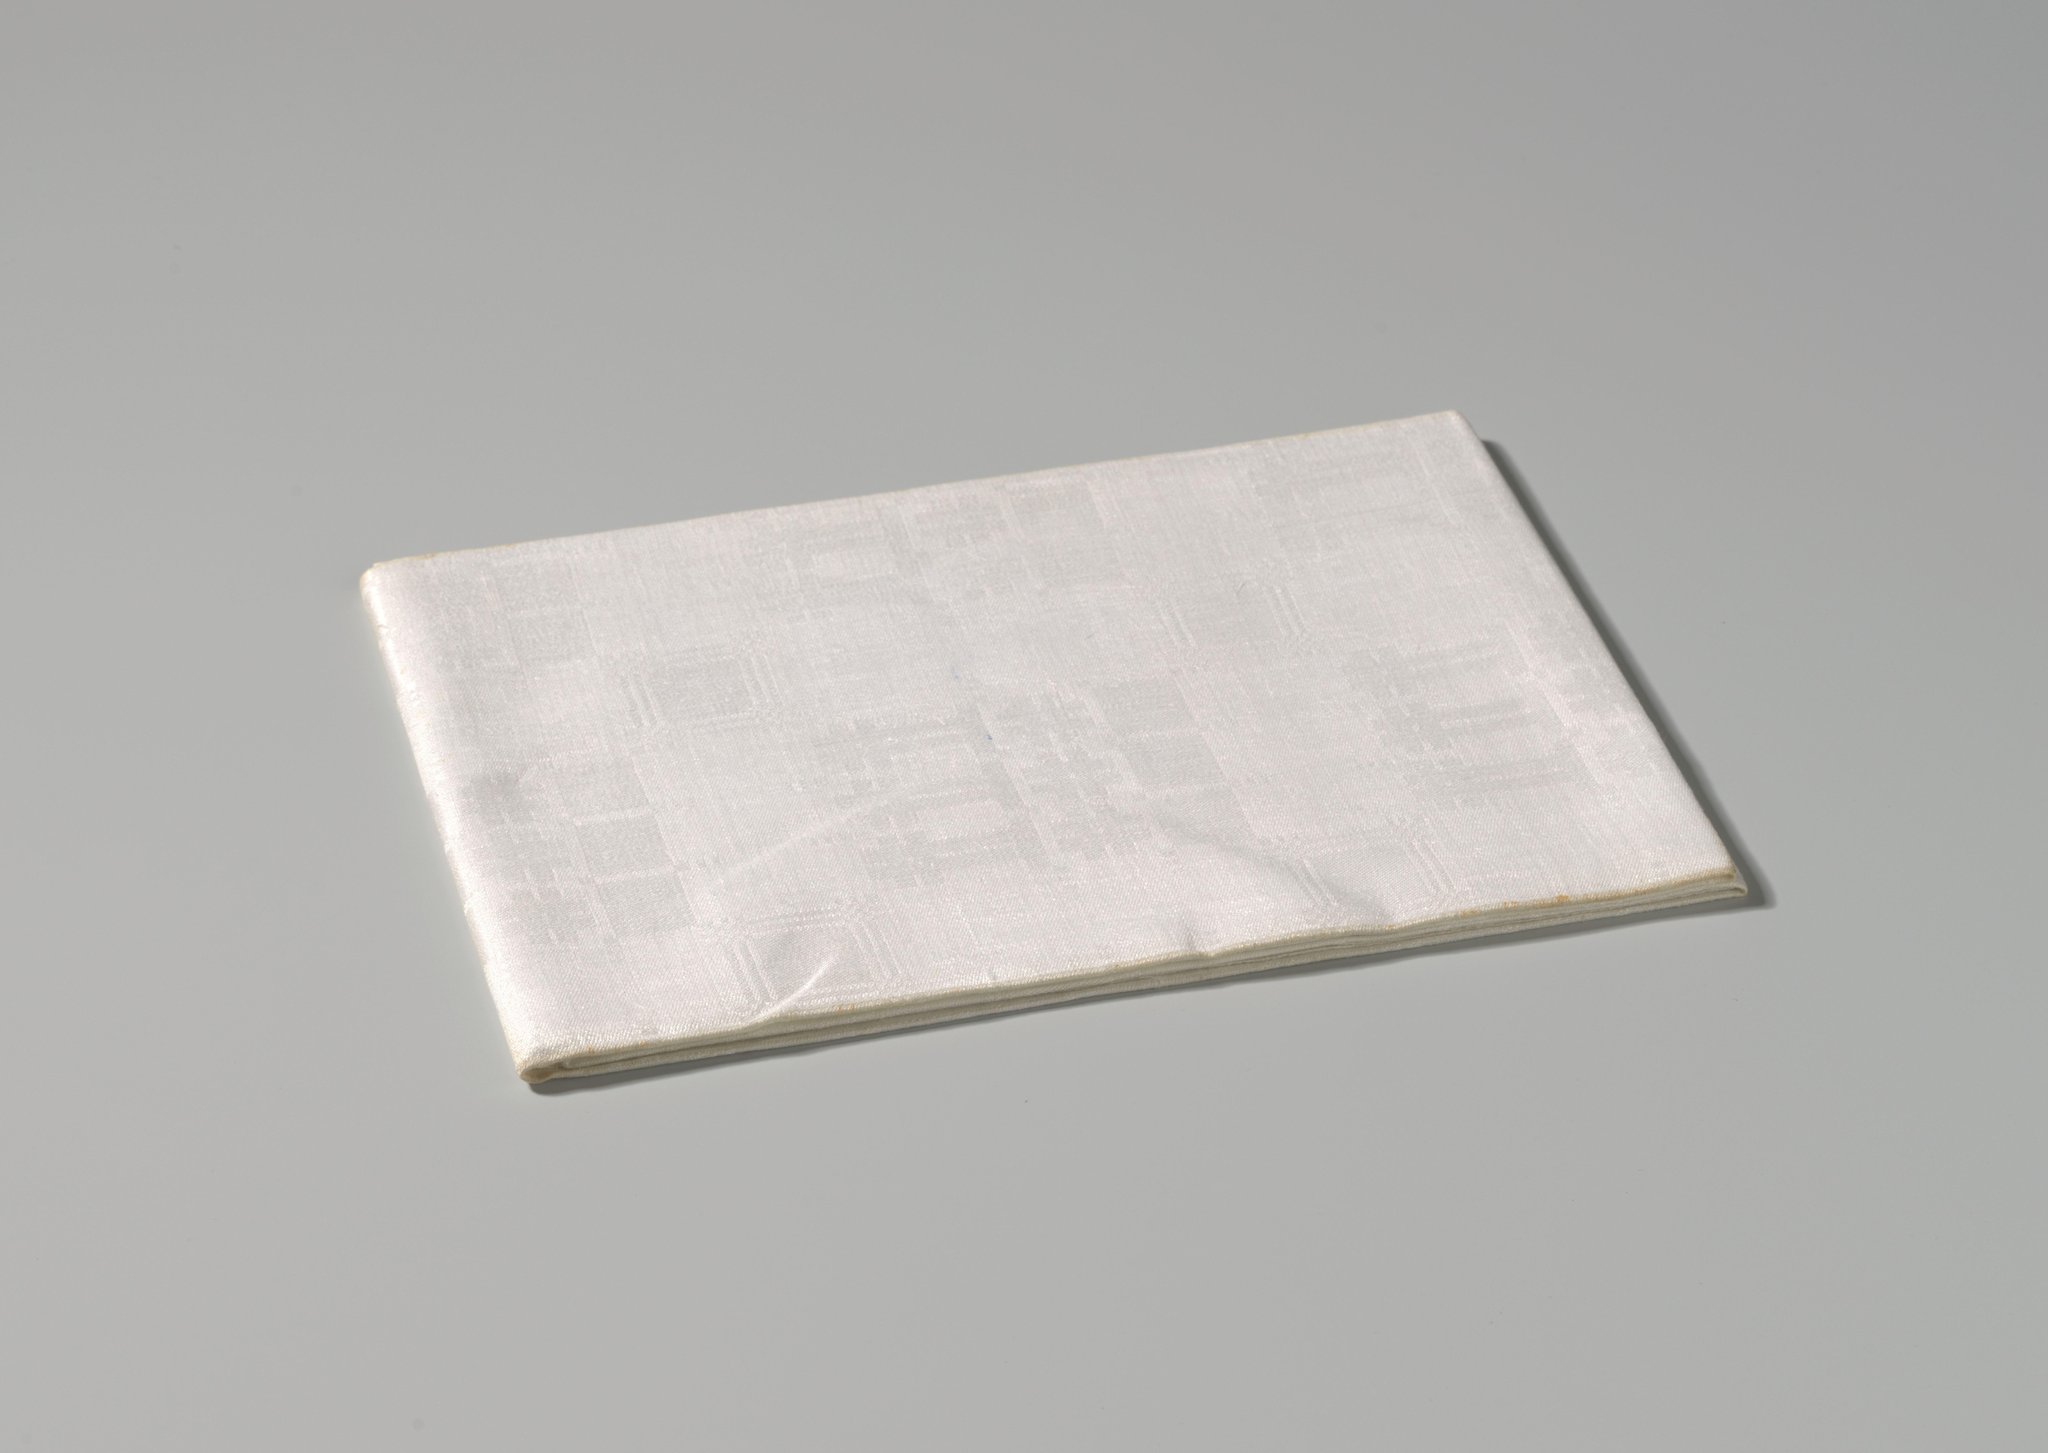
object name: napkin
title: Servet van linnen met pellenpatroon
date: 1725-1769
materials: linen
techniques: peeled fabric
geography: northern netherlands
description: wit linnen servet met pellen patroon, merk kroon ARVG 31